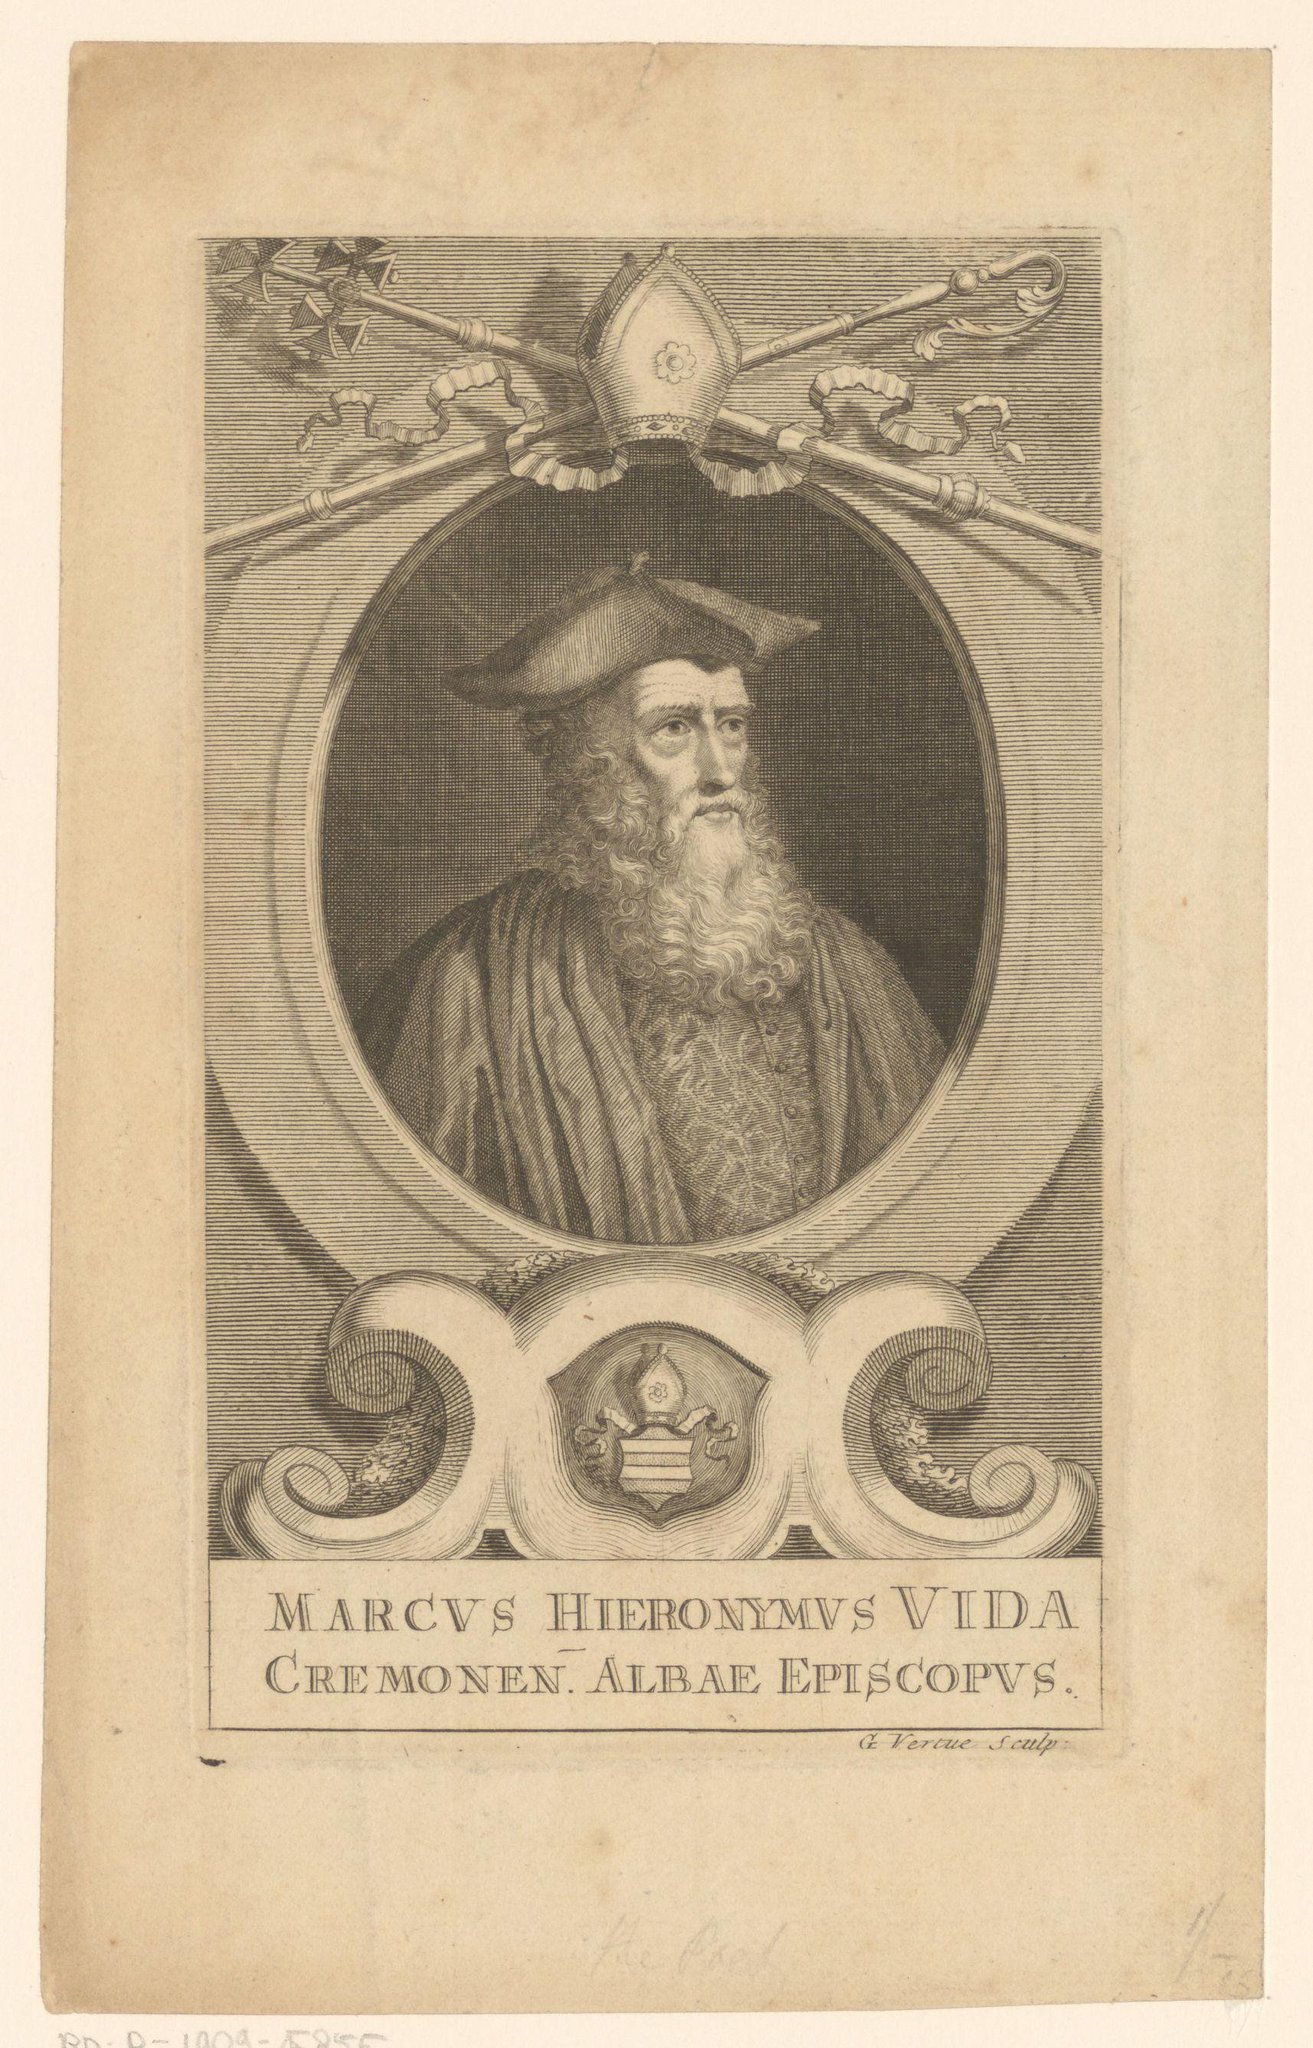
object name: print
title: Portret van Marco Girolamo Vida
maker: george vertue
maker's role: print maker, publisher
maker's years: 1684-1756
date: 1694-1756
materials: paper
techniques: engraving, etching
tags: historical persons, writer, poet, author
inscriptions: collector's mark: Lugt 2228